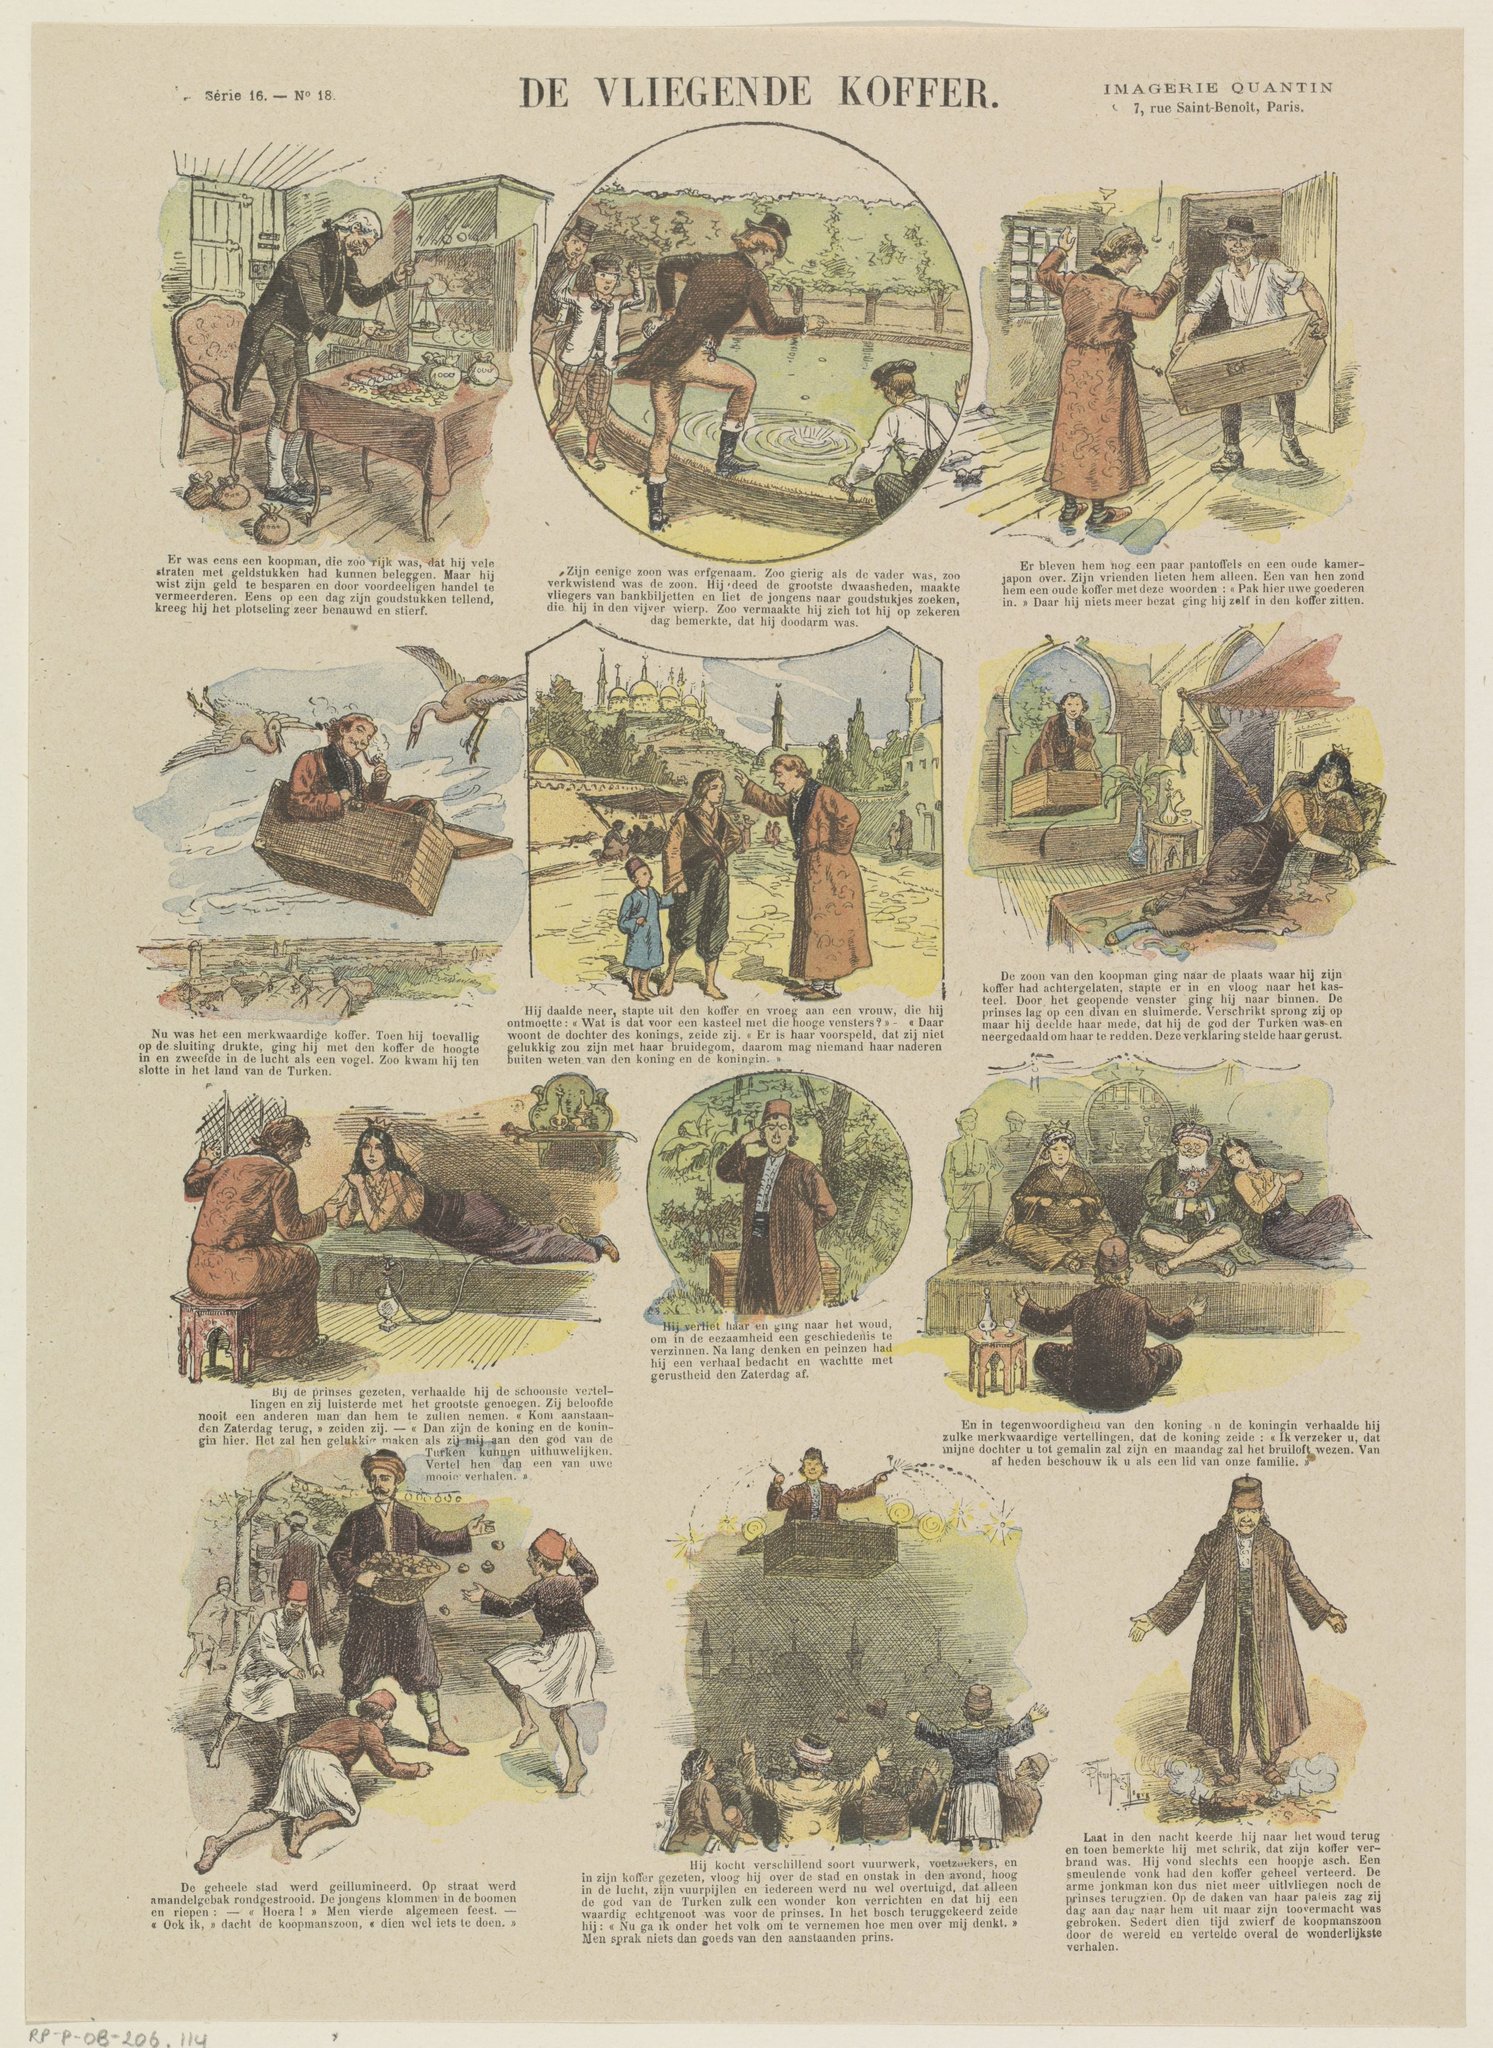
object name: popular print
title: De vliegende koffer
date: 1876-1890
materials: paper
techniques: lithograph, letterpress printing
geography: paris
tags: tales and fairy tales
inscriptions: collector's mark: Lugt 2760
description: Blad met 12 voorstellingen uit het sprookje van de vliegende koffer. Onder elke afbeelding een onderschrift. Genummerd linksboven: Série 16. - No. 18.